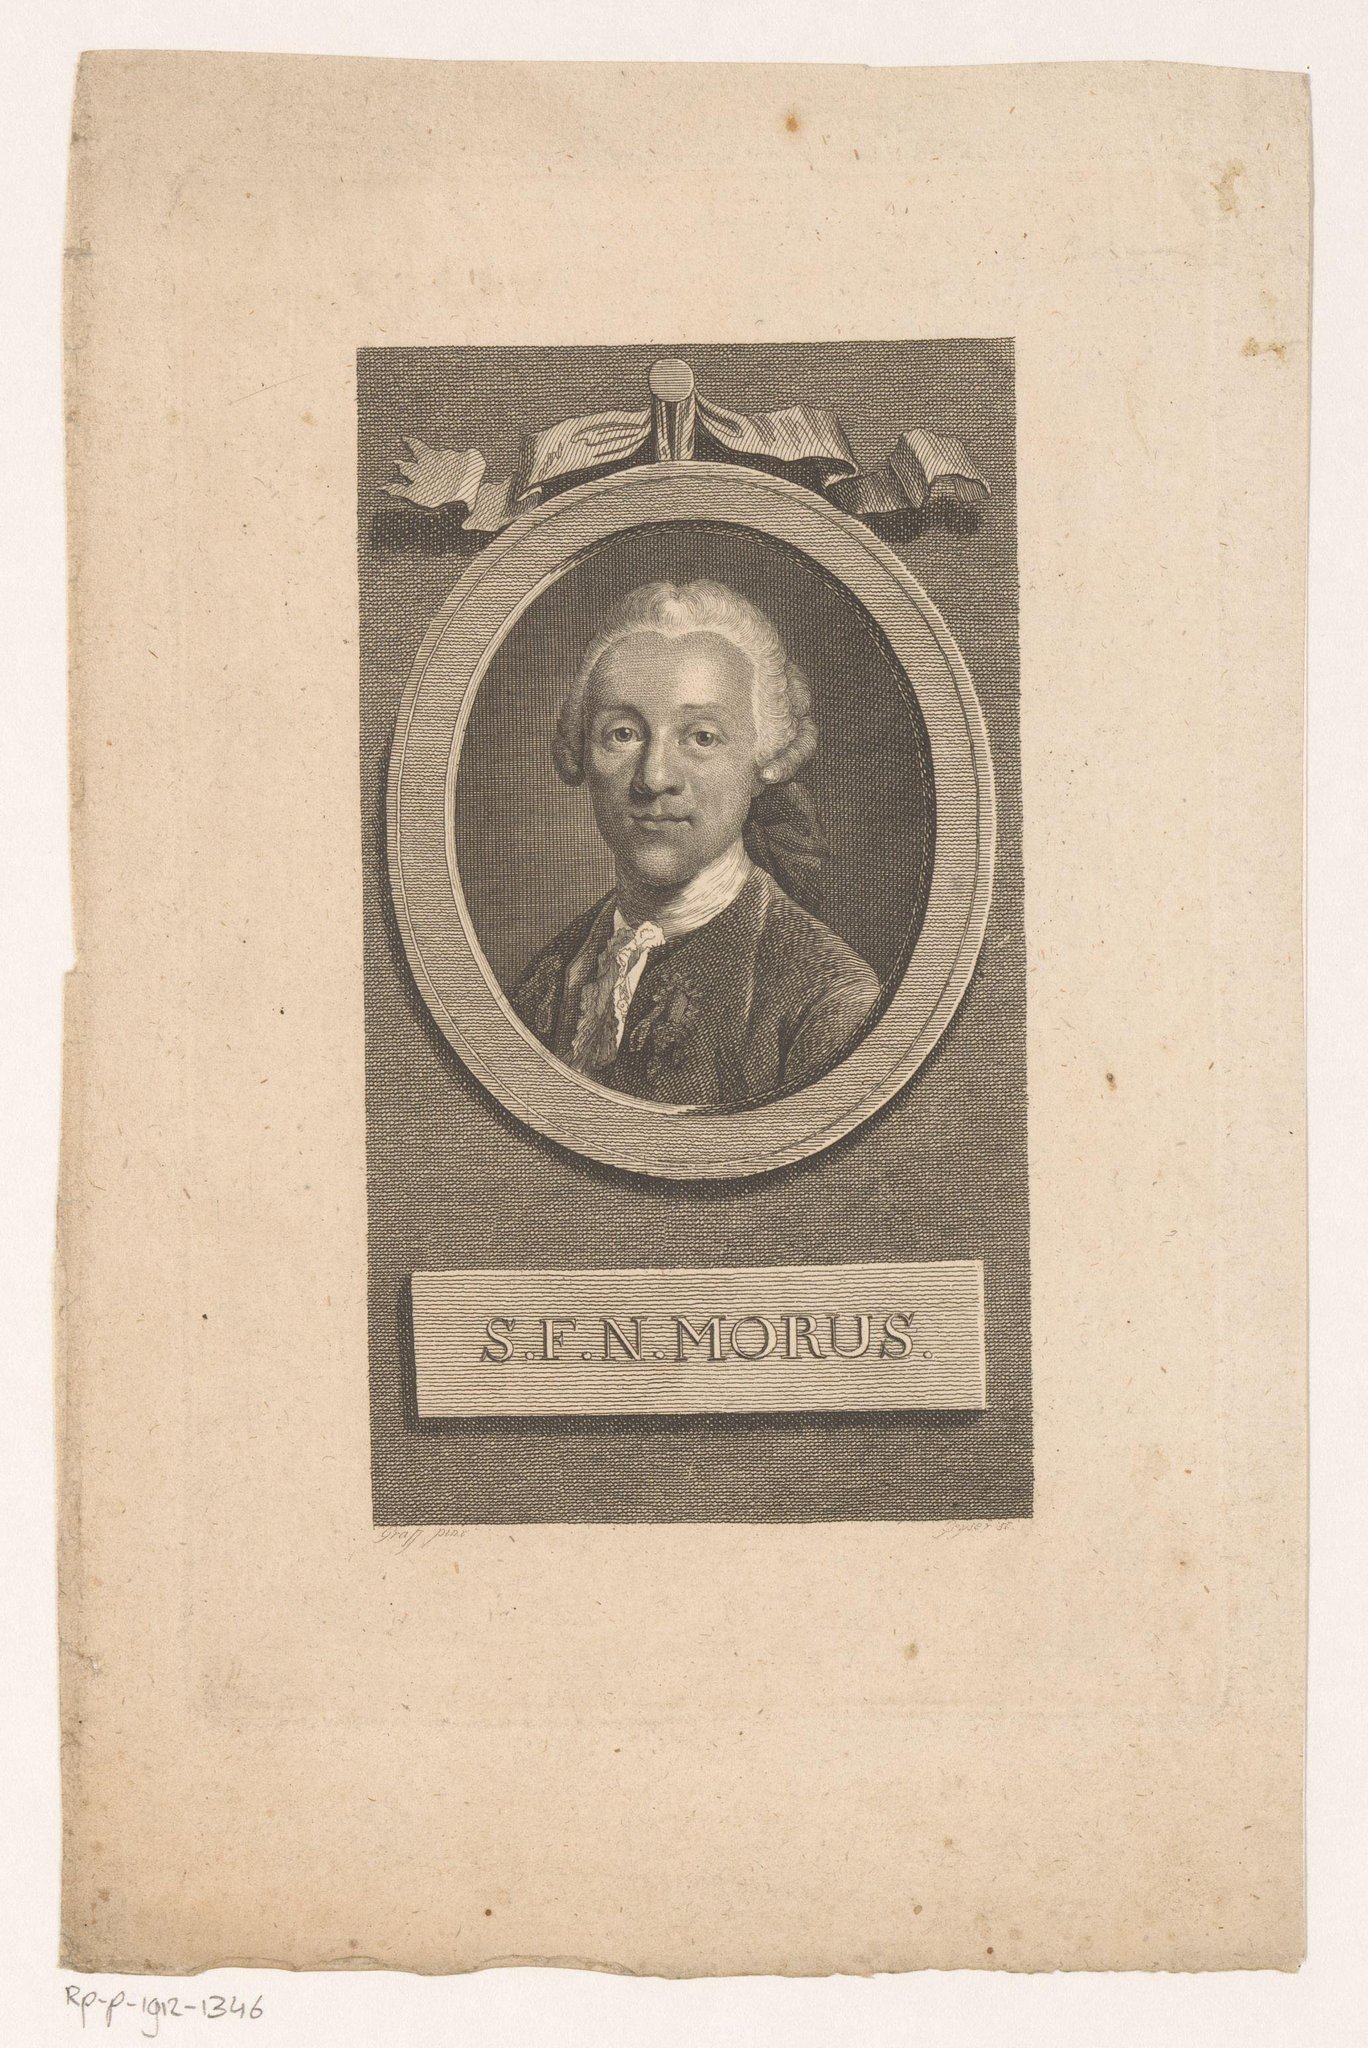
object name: print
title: Portret van Samuel Friedrich Nathanael Morus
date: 1752-1792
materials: paper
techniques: engraving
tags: ornament ~ medallion, historical persons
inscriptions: collector's mark: Lugt 2228